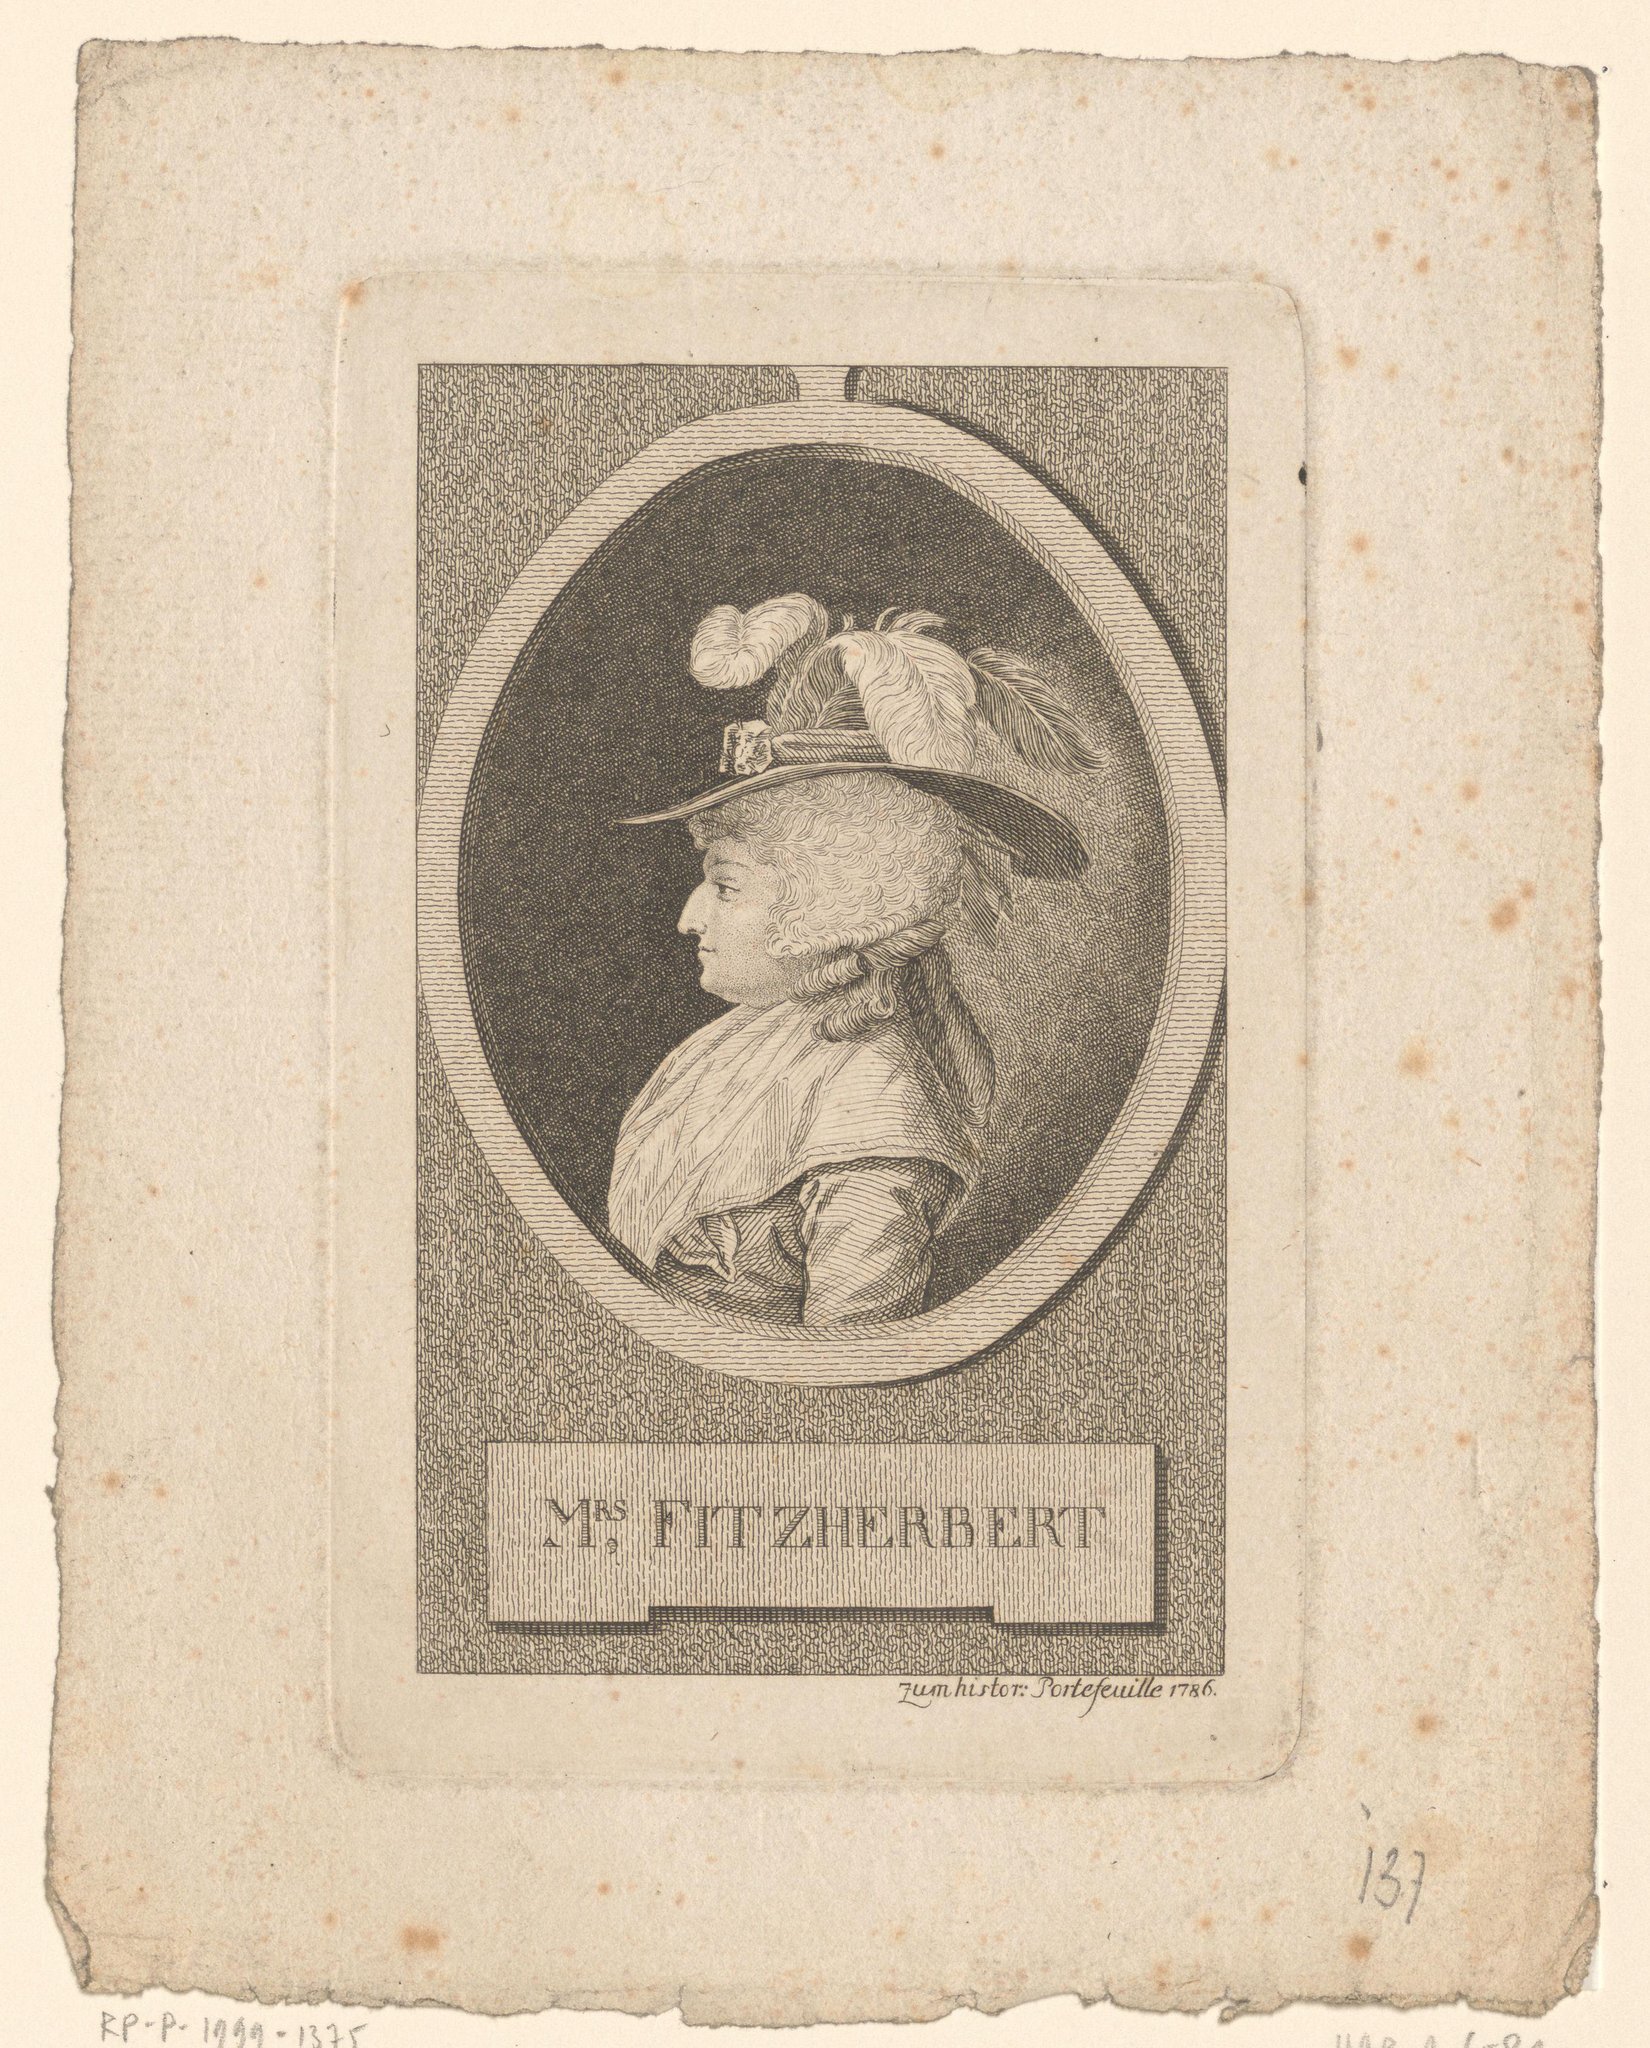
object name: print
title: Portret van Maria Fitzherbert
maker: Anonymous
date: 1786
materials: paper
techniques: etching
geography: germany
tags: historical persons - bb - woman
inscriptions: collector's mark: Lugt 2760, collector's mark: Lugt 2228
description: Prent waarschijnlijk uit: Historisches Portefeuille 10 (1786), oktober 1786.